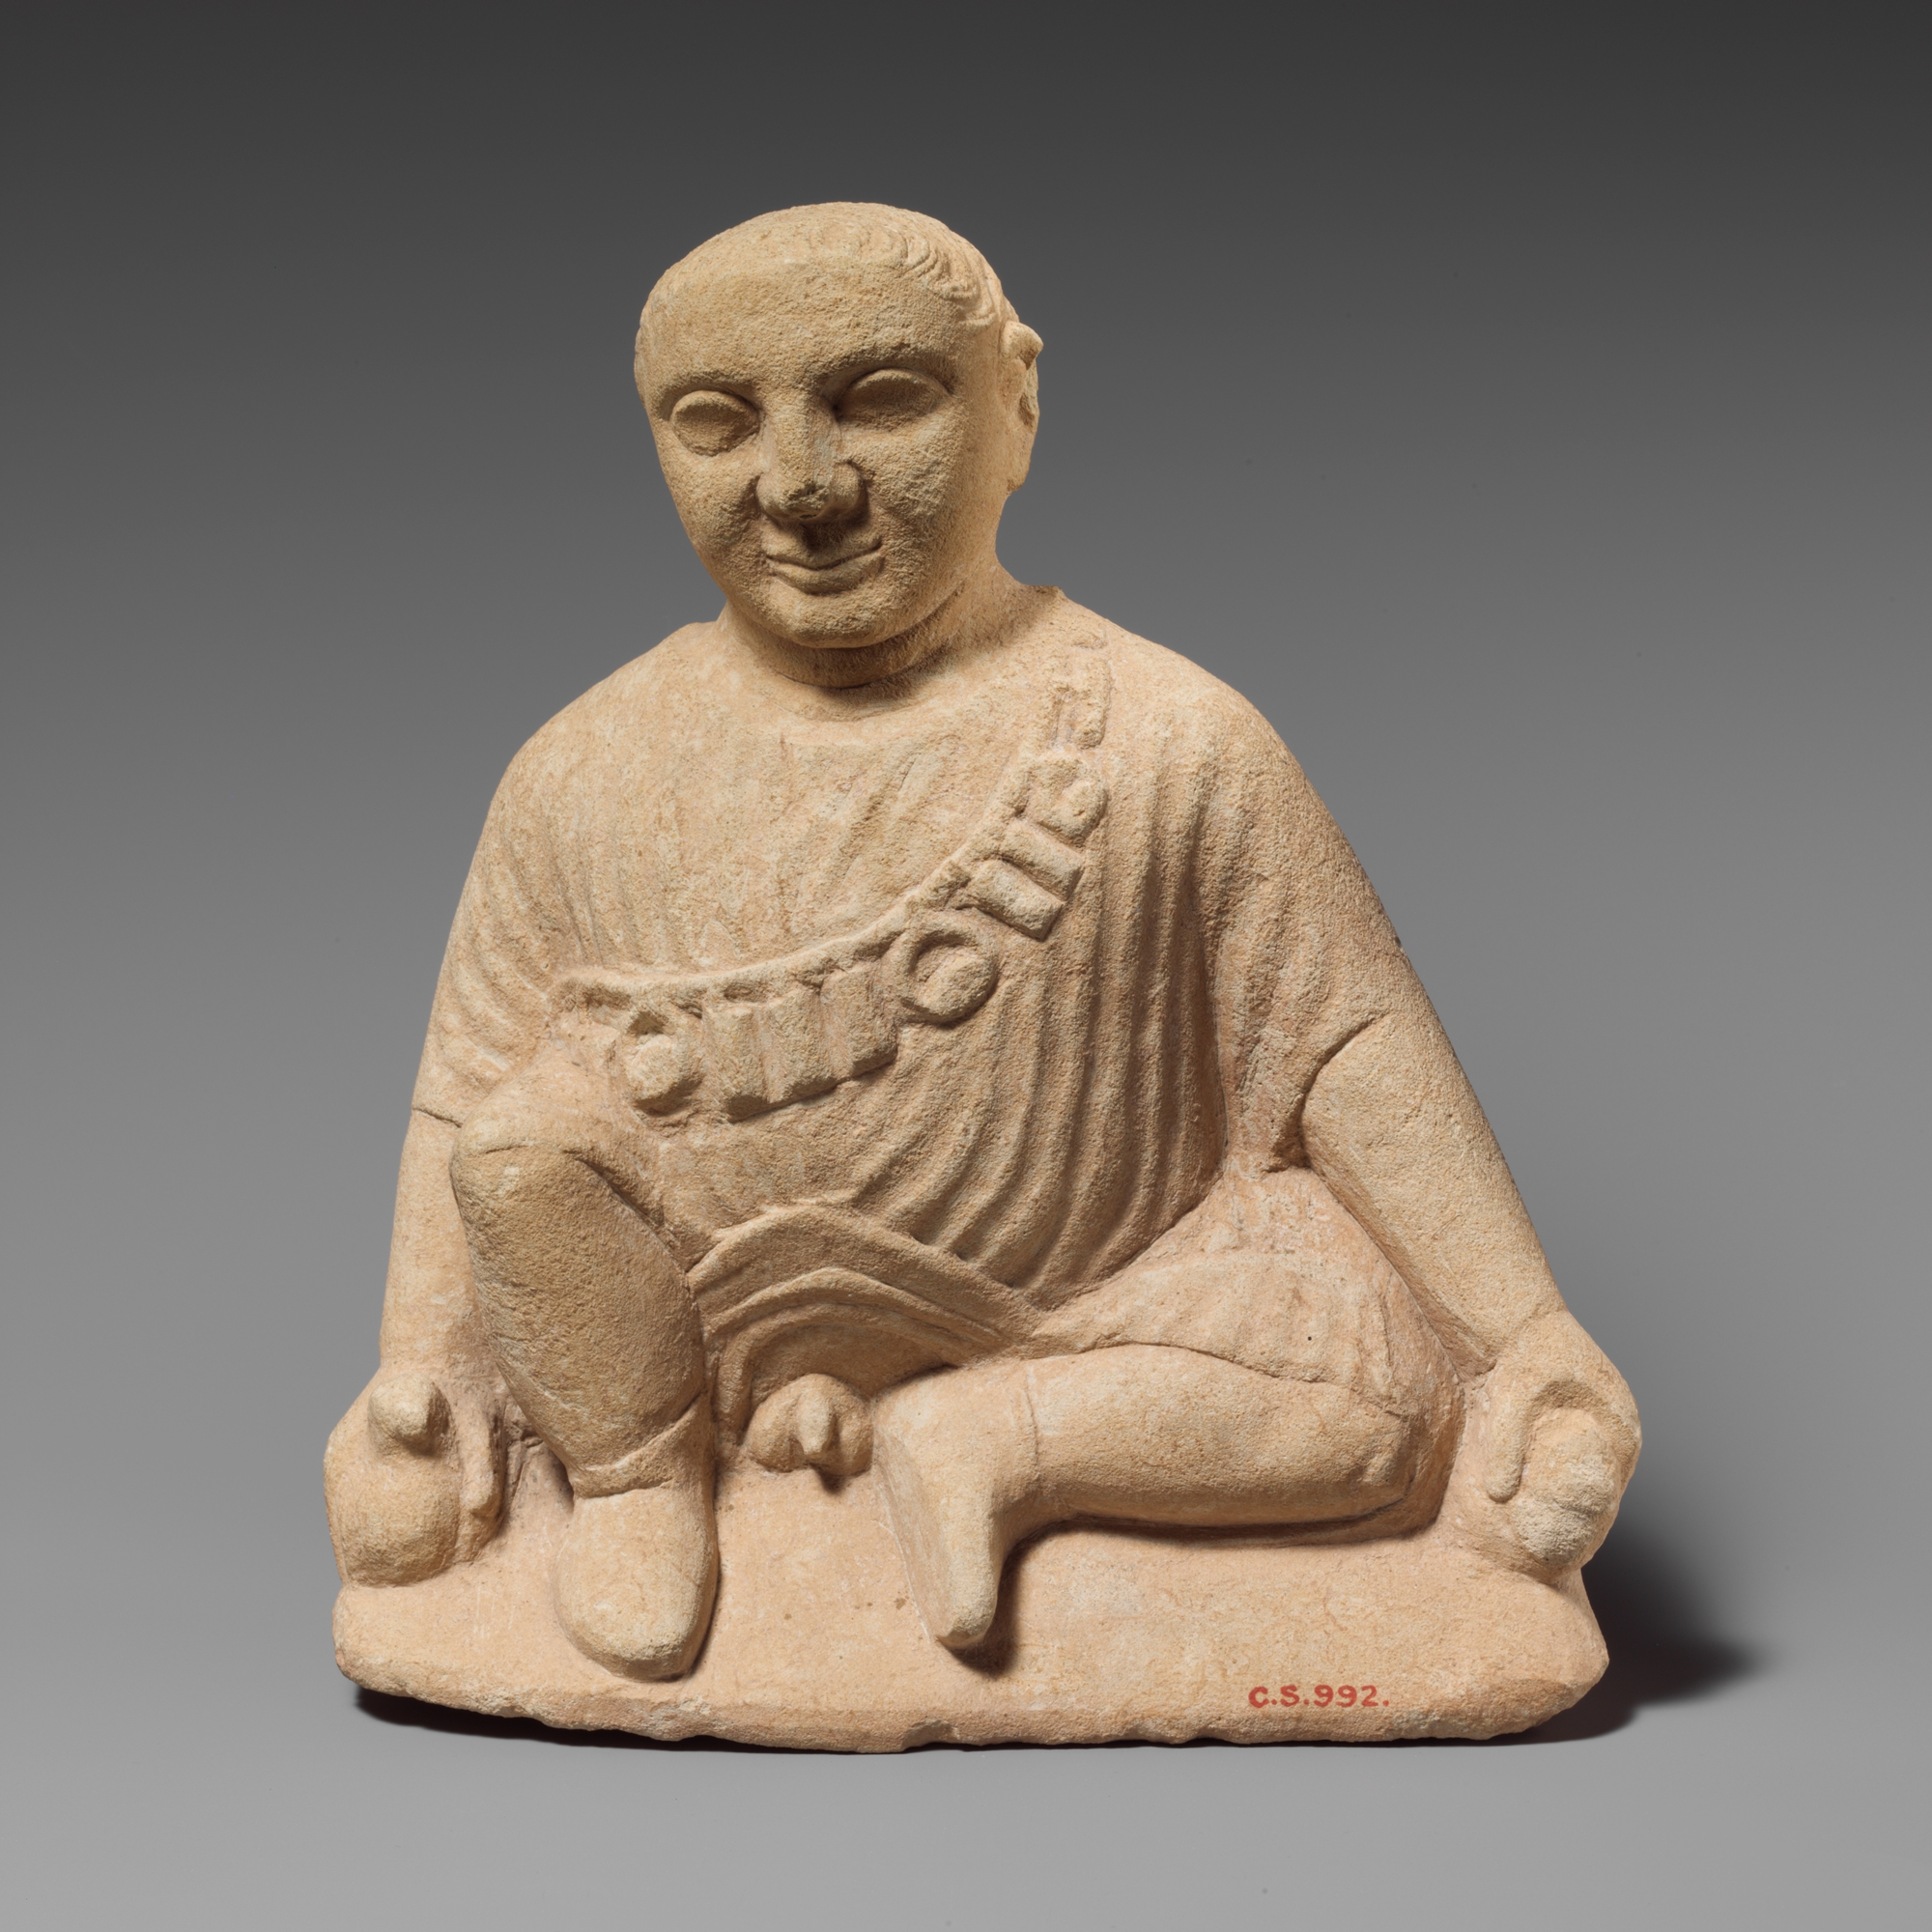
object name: statuette of a temple boy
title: Limestone statuette of a temple boy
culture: cypriot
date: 310-30 BCE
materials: limestone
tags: doves,pendants,boys